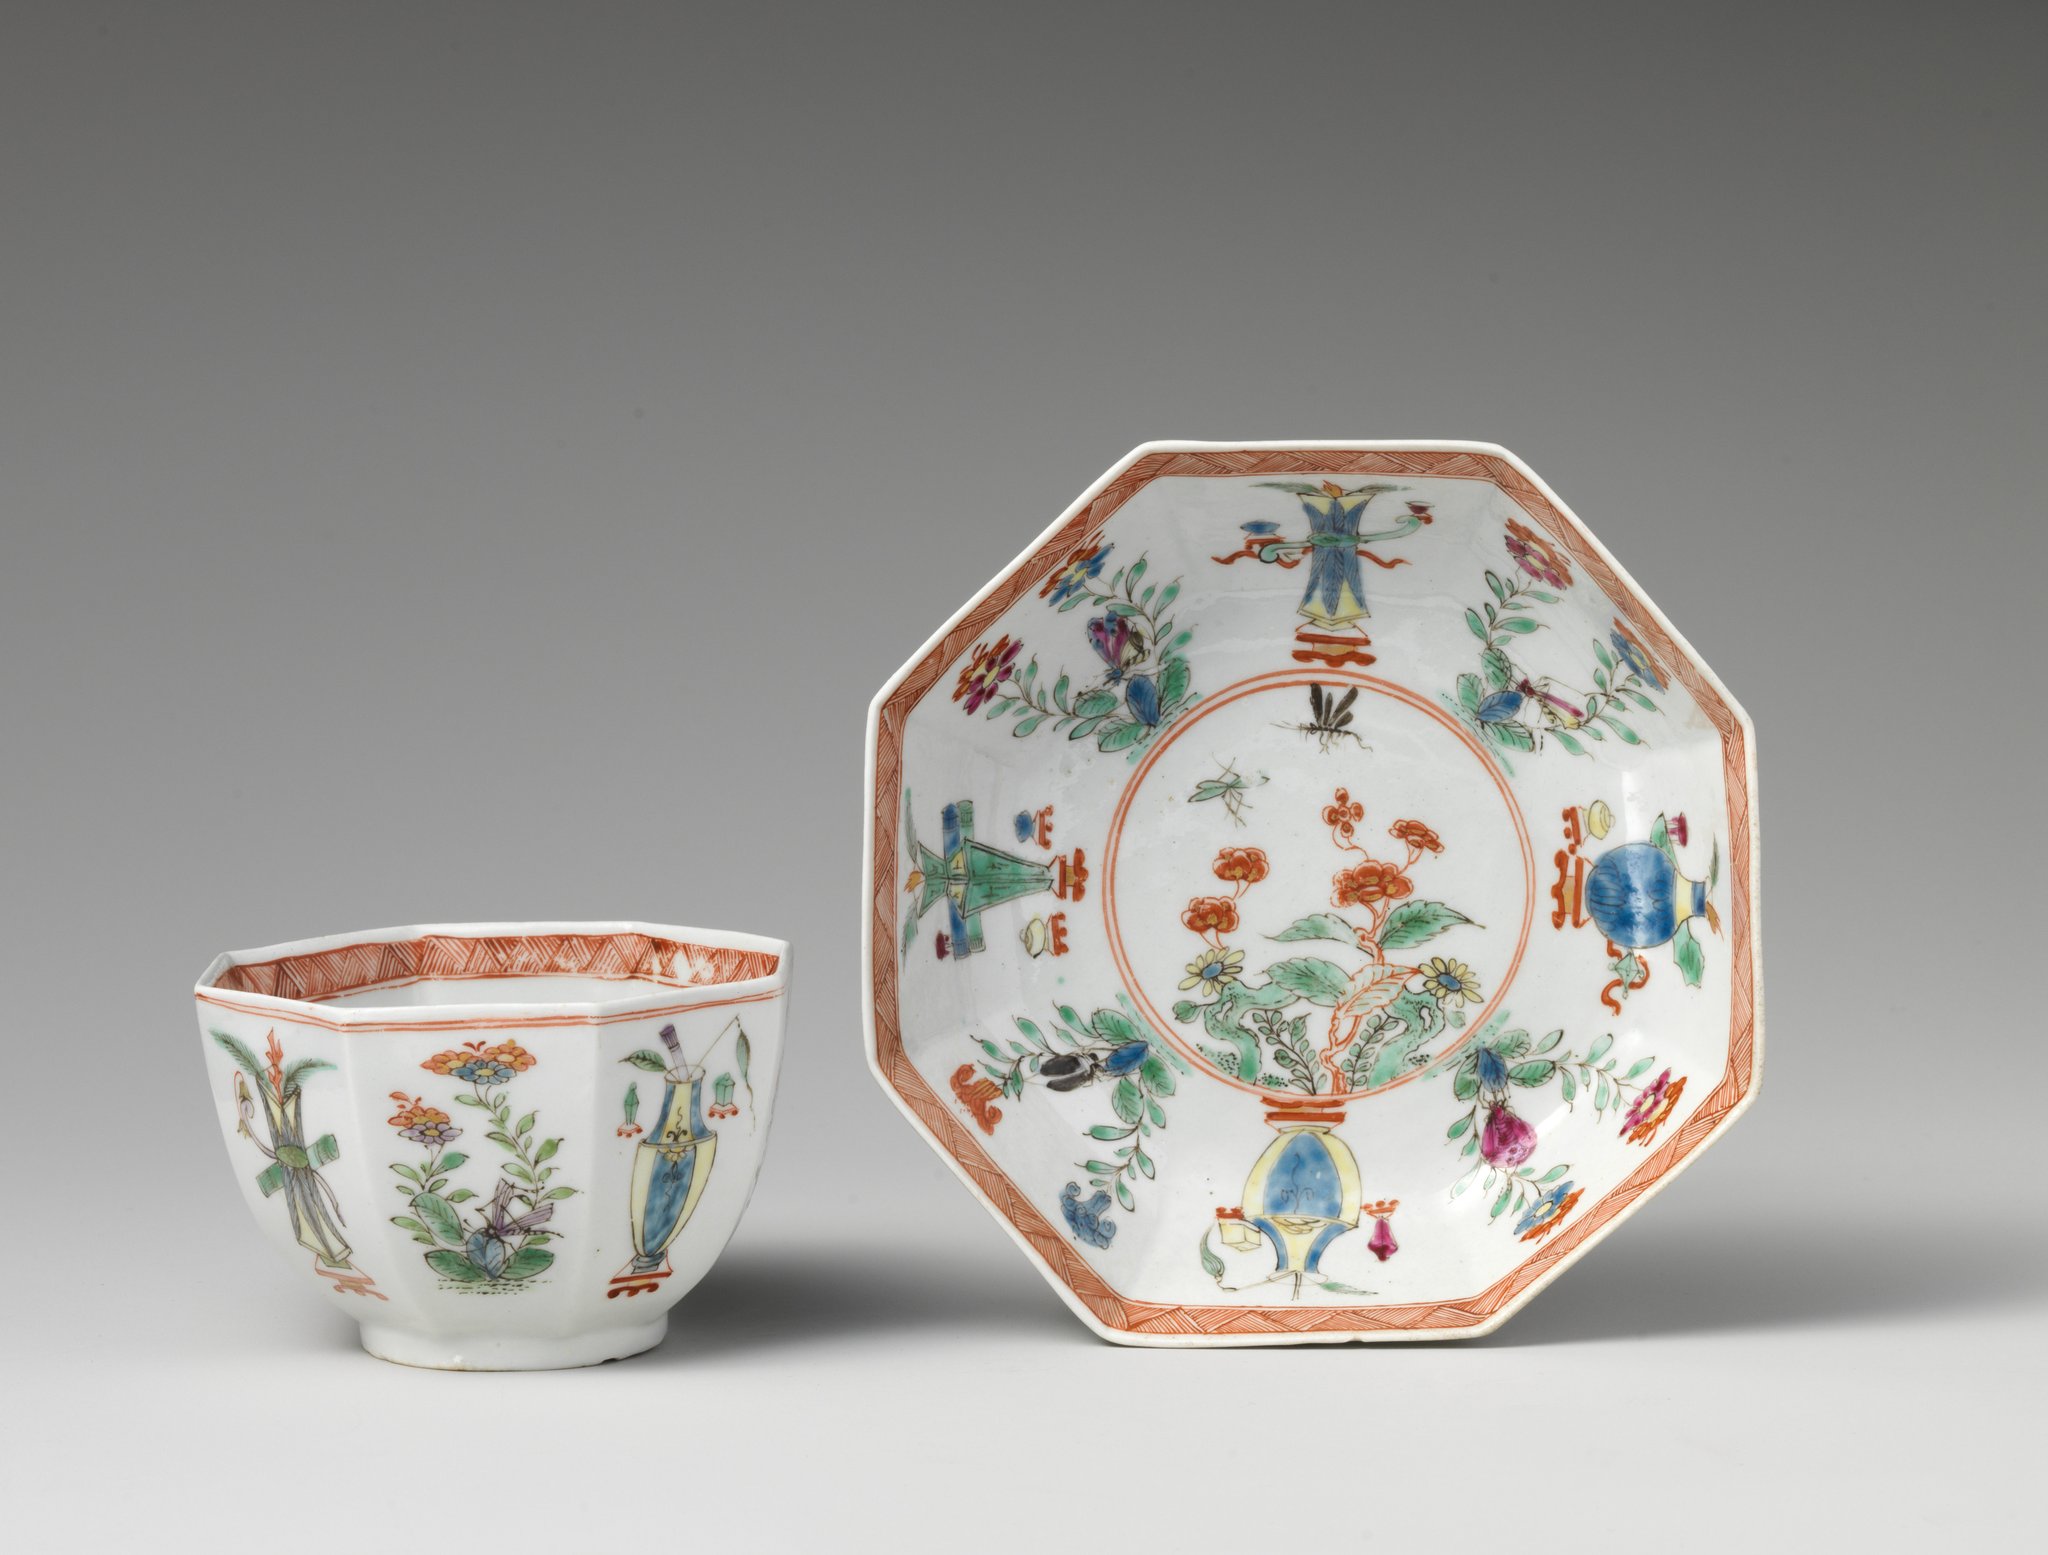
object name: cup and saucer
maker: worcester factory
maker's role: maker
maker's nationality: british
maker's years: 1751-2008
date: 1701-1800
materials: soft paste porcelain